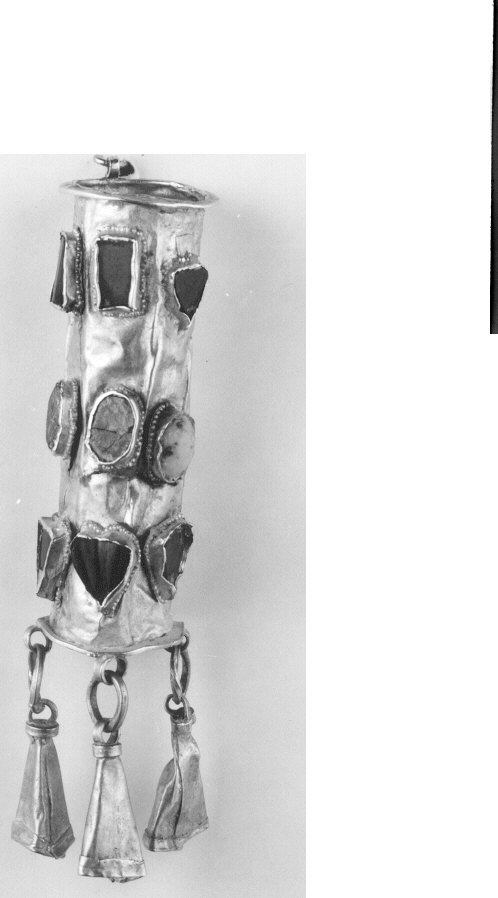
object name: hair ornament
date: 1101-1200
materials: garnet, gold, stone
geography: iran